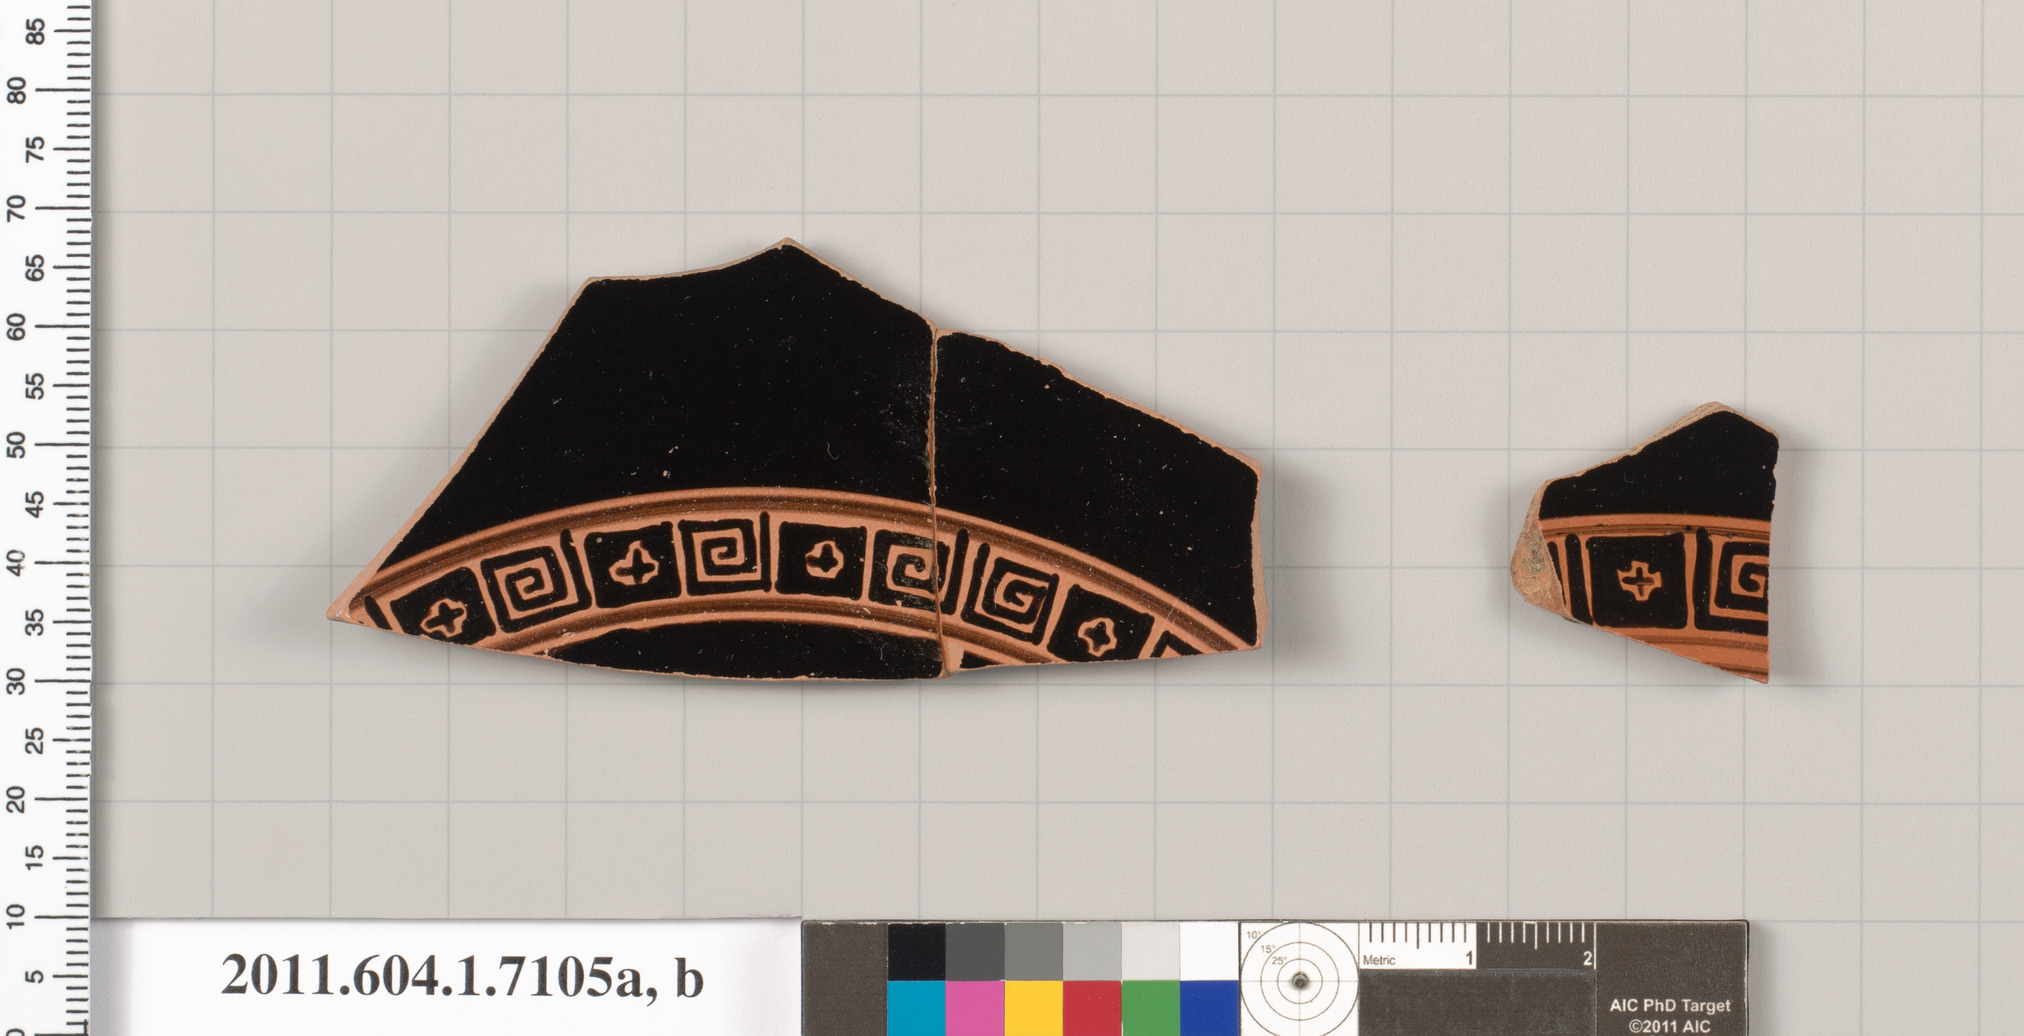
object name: kylix fragment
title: Terracotta fragments of kylikes (drinking cups)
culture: greek, attic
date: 500-480 BCE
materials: terracotta